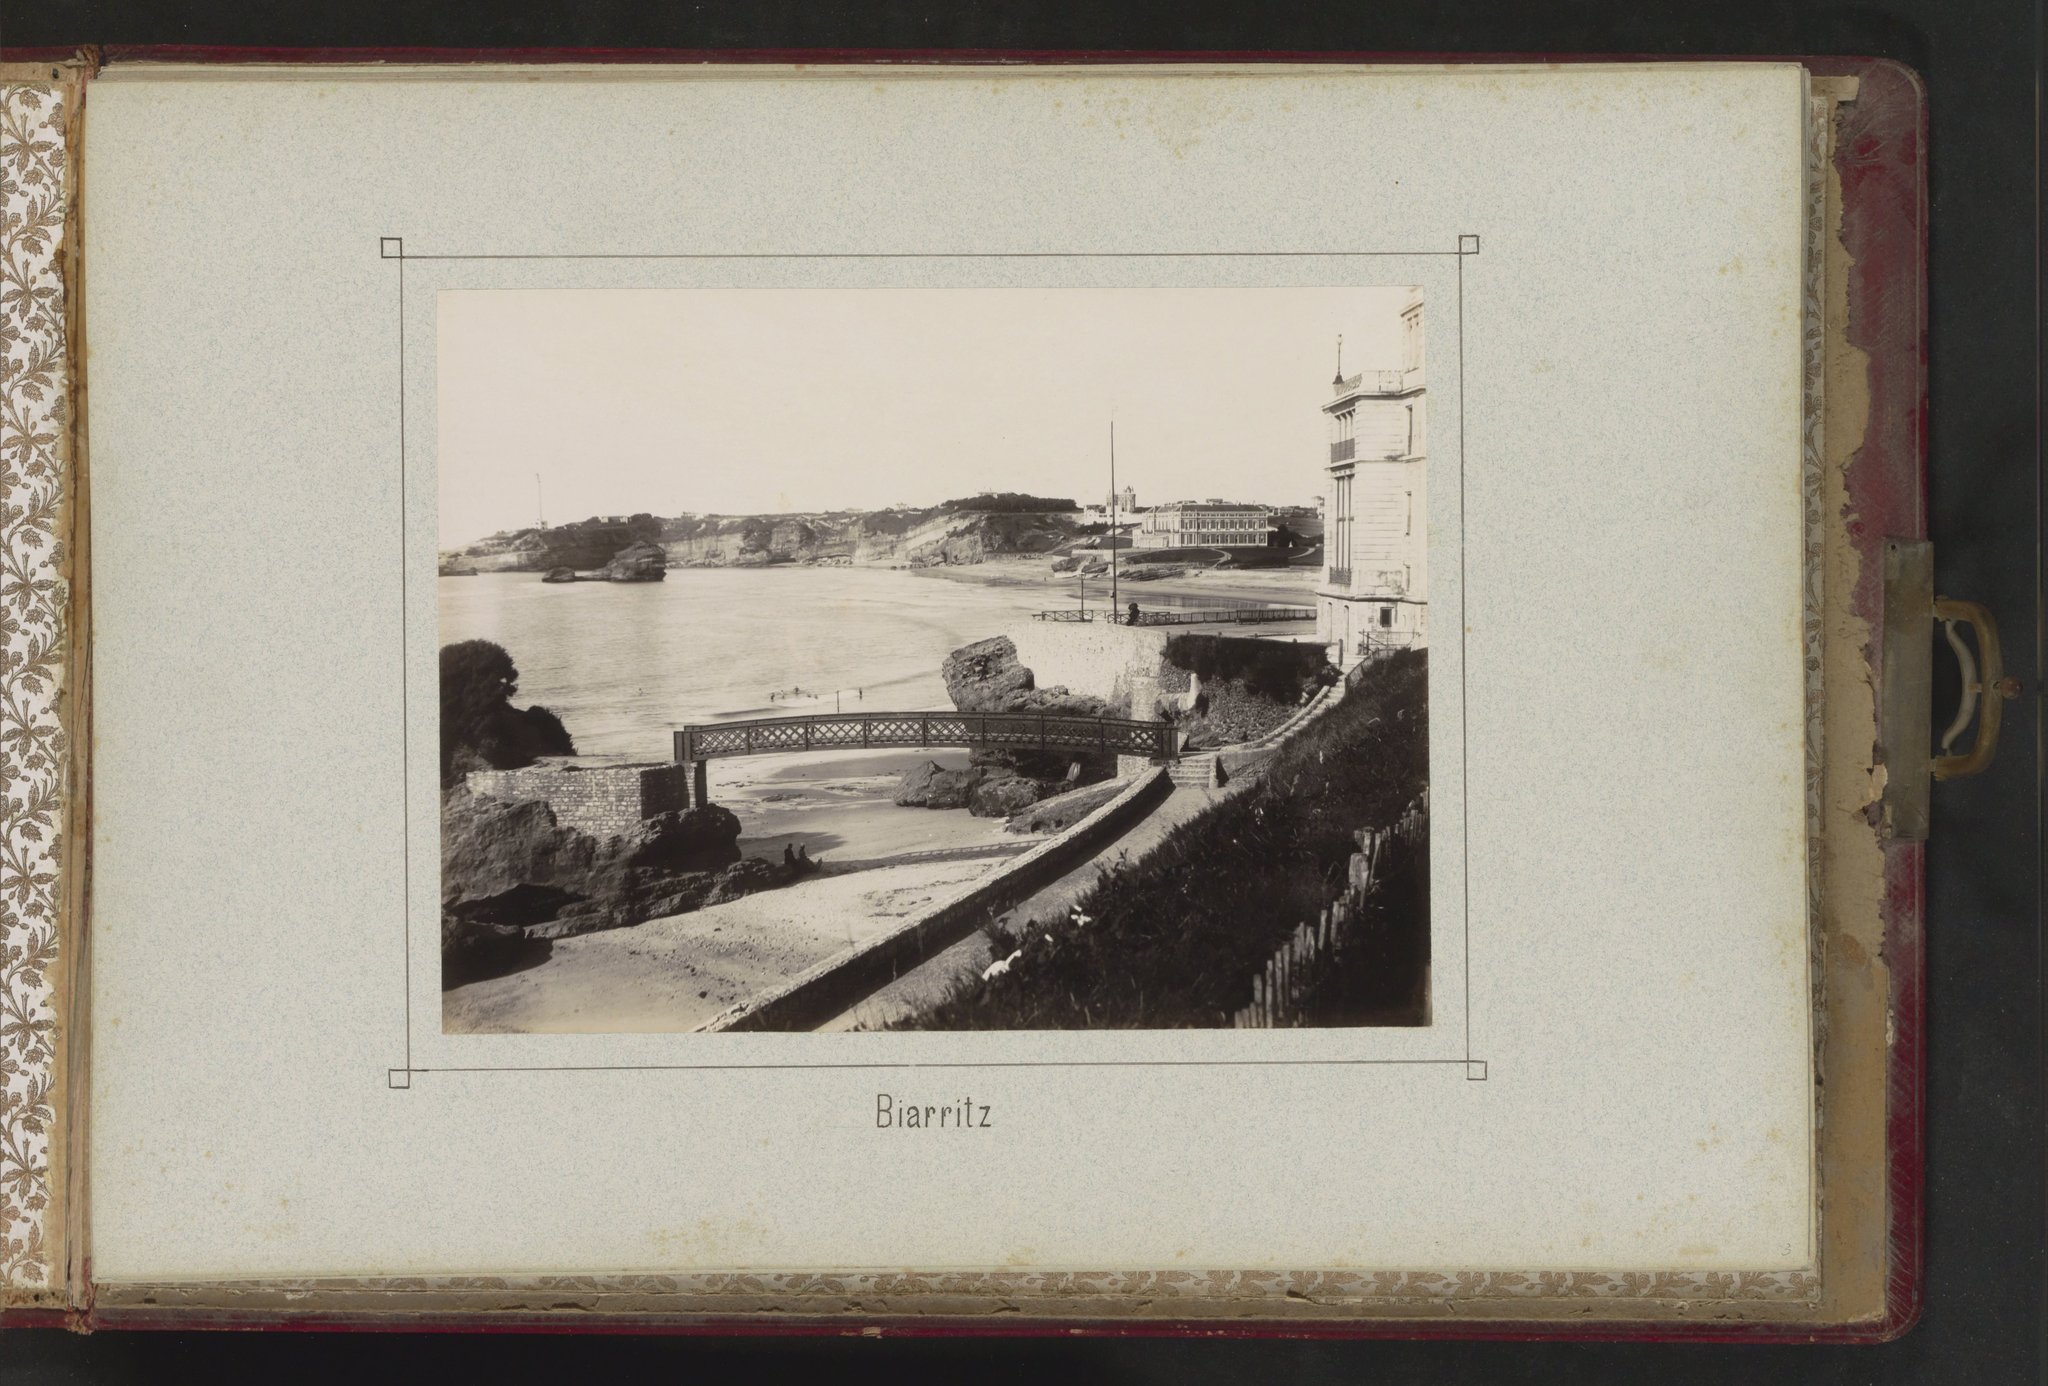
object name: photograph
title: Biarritz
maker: Anonymous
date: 1880-1900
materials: photographic support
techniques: albumen print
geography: biarritz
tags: coast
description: Onderdeel van Reisalbum met foto's van Zuid-Afrika, Madeira, Portugal, Frankrijk en Duitsland.